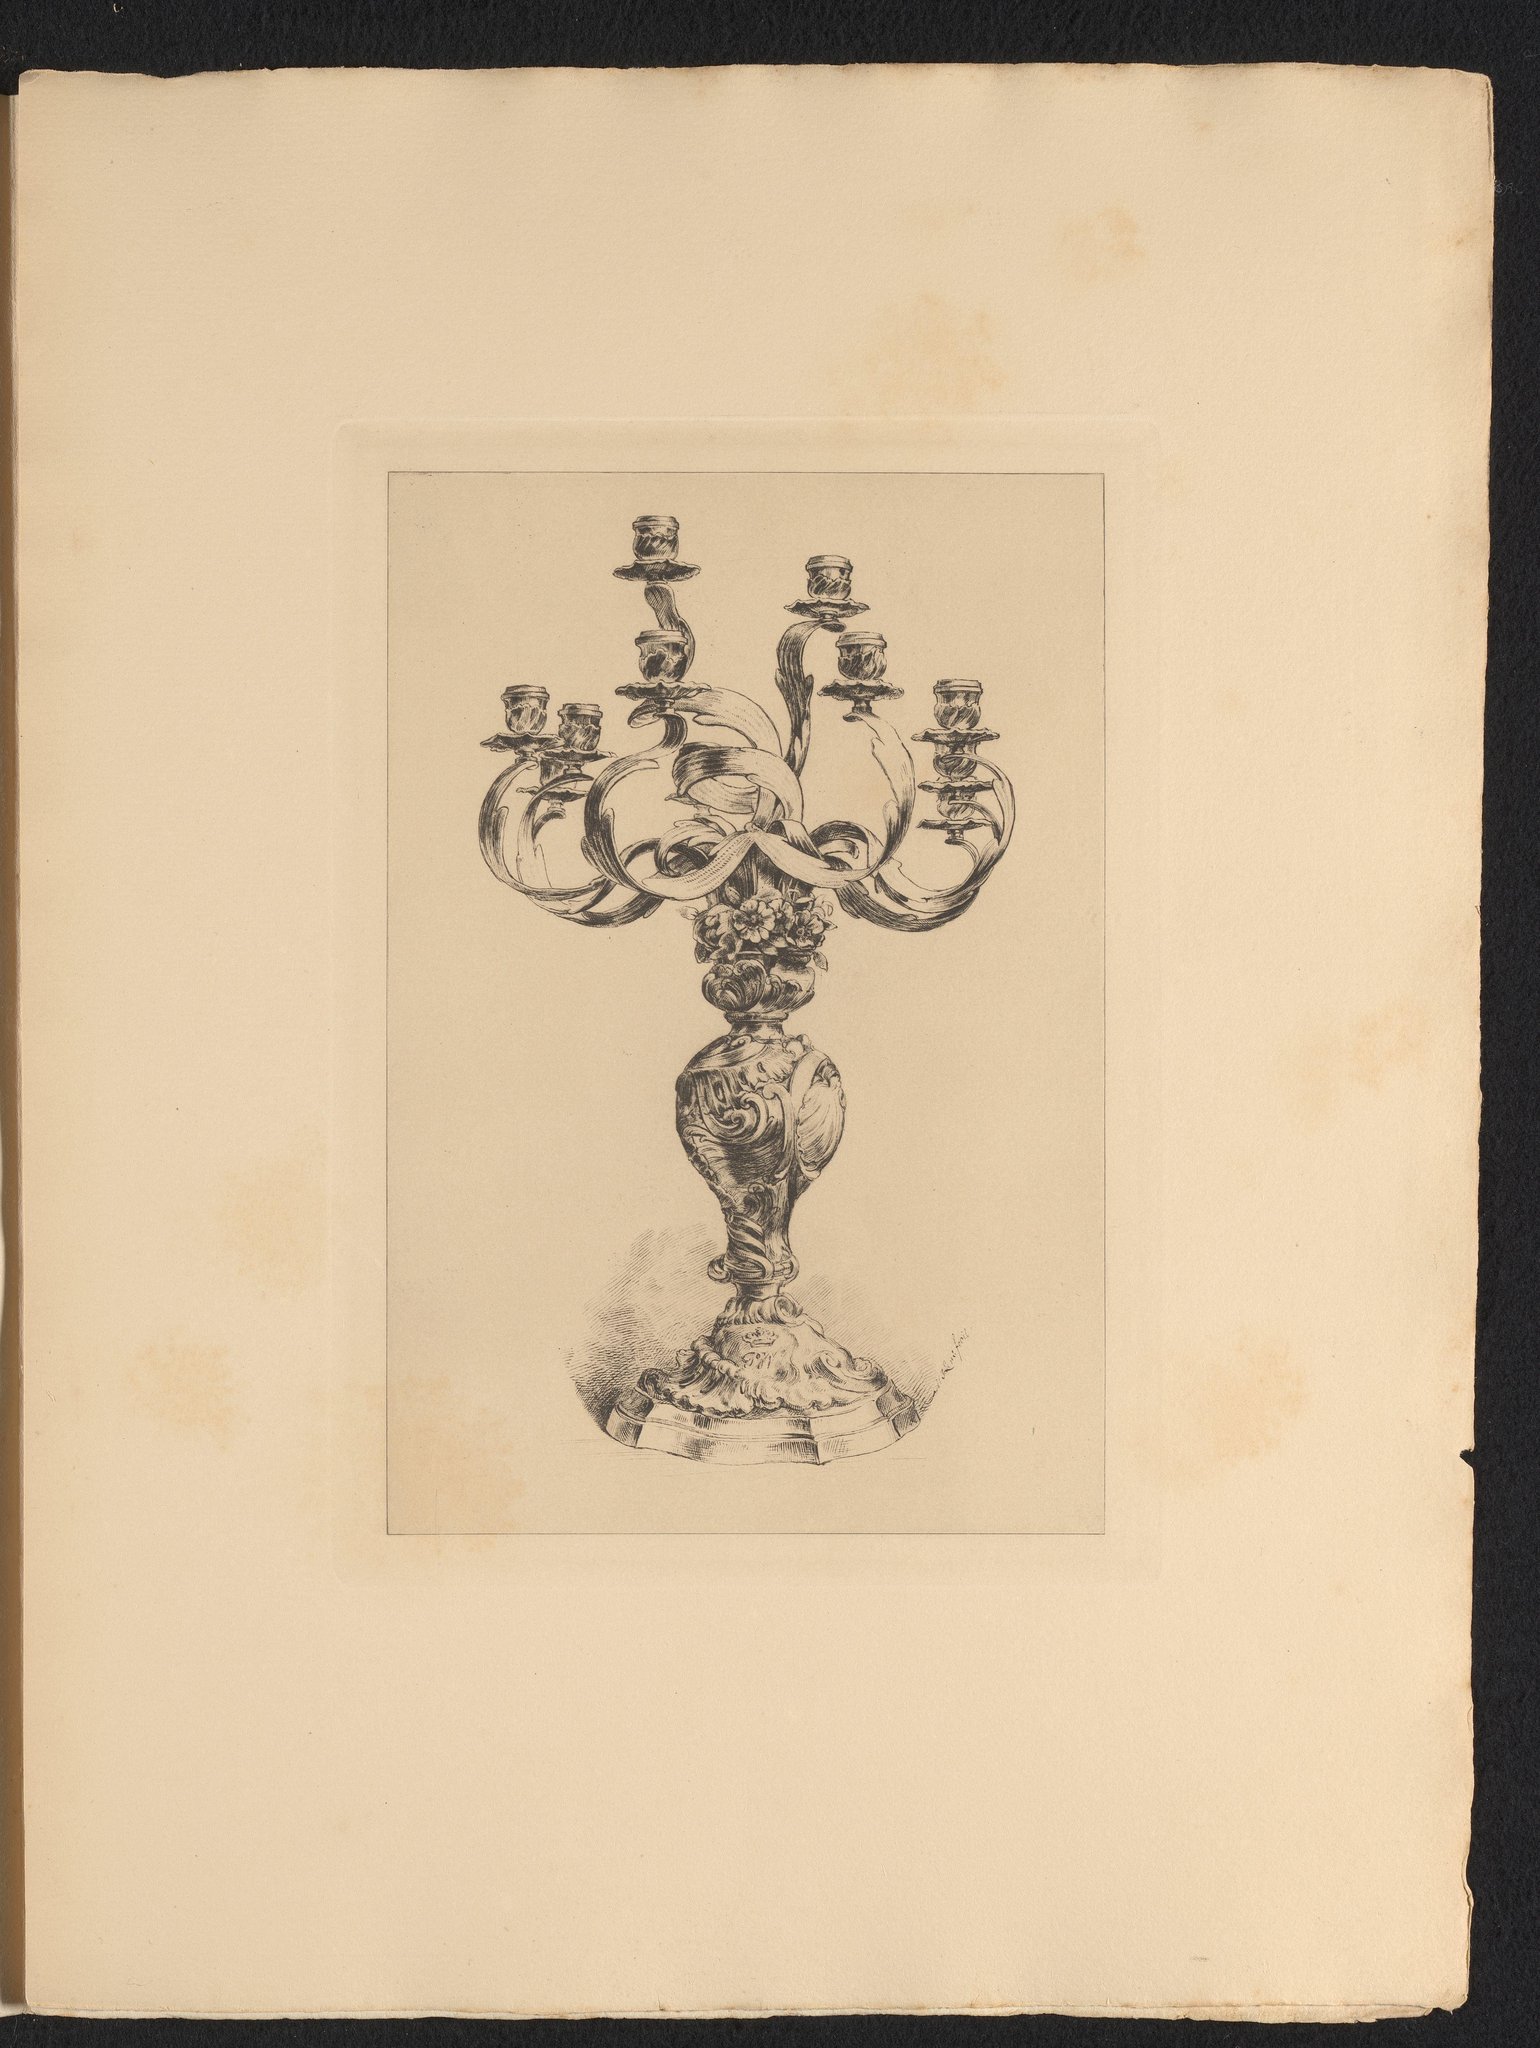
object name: print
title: Candelabre a douze branches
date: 1889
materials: paper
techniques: etching, intaglio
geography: utrecht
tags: candlestick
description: Prent maakt deel uit van een serie van veertien prenten.